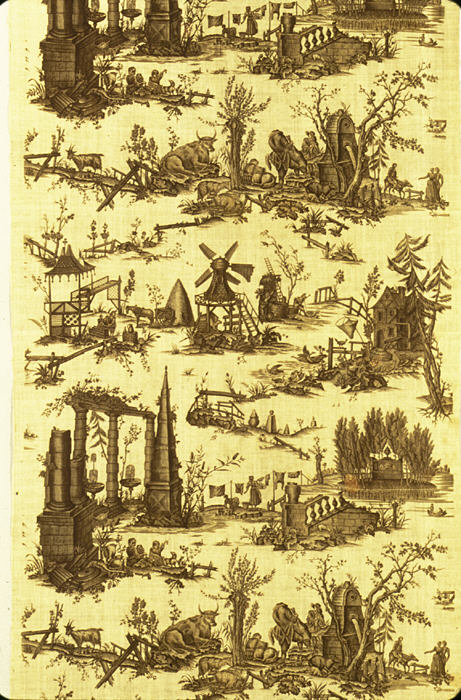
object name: fragment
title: "Tomb of Rousseau"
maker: petitpierre et cie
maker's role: manufactory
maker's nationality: french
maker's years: 1790-1802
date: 1790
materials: cotton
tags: animals,tombs,windmills,cows,trees